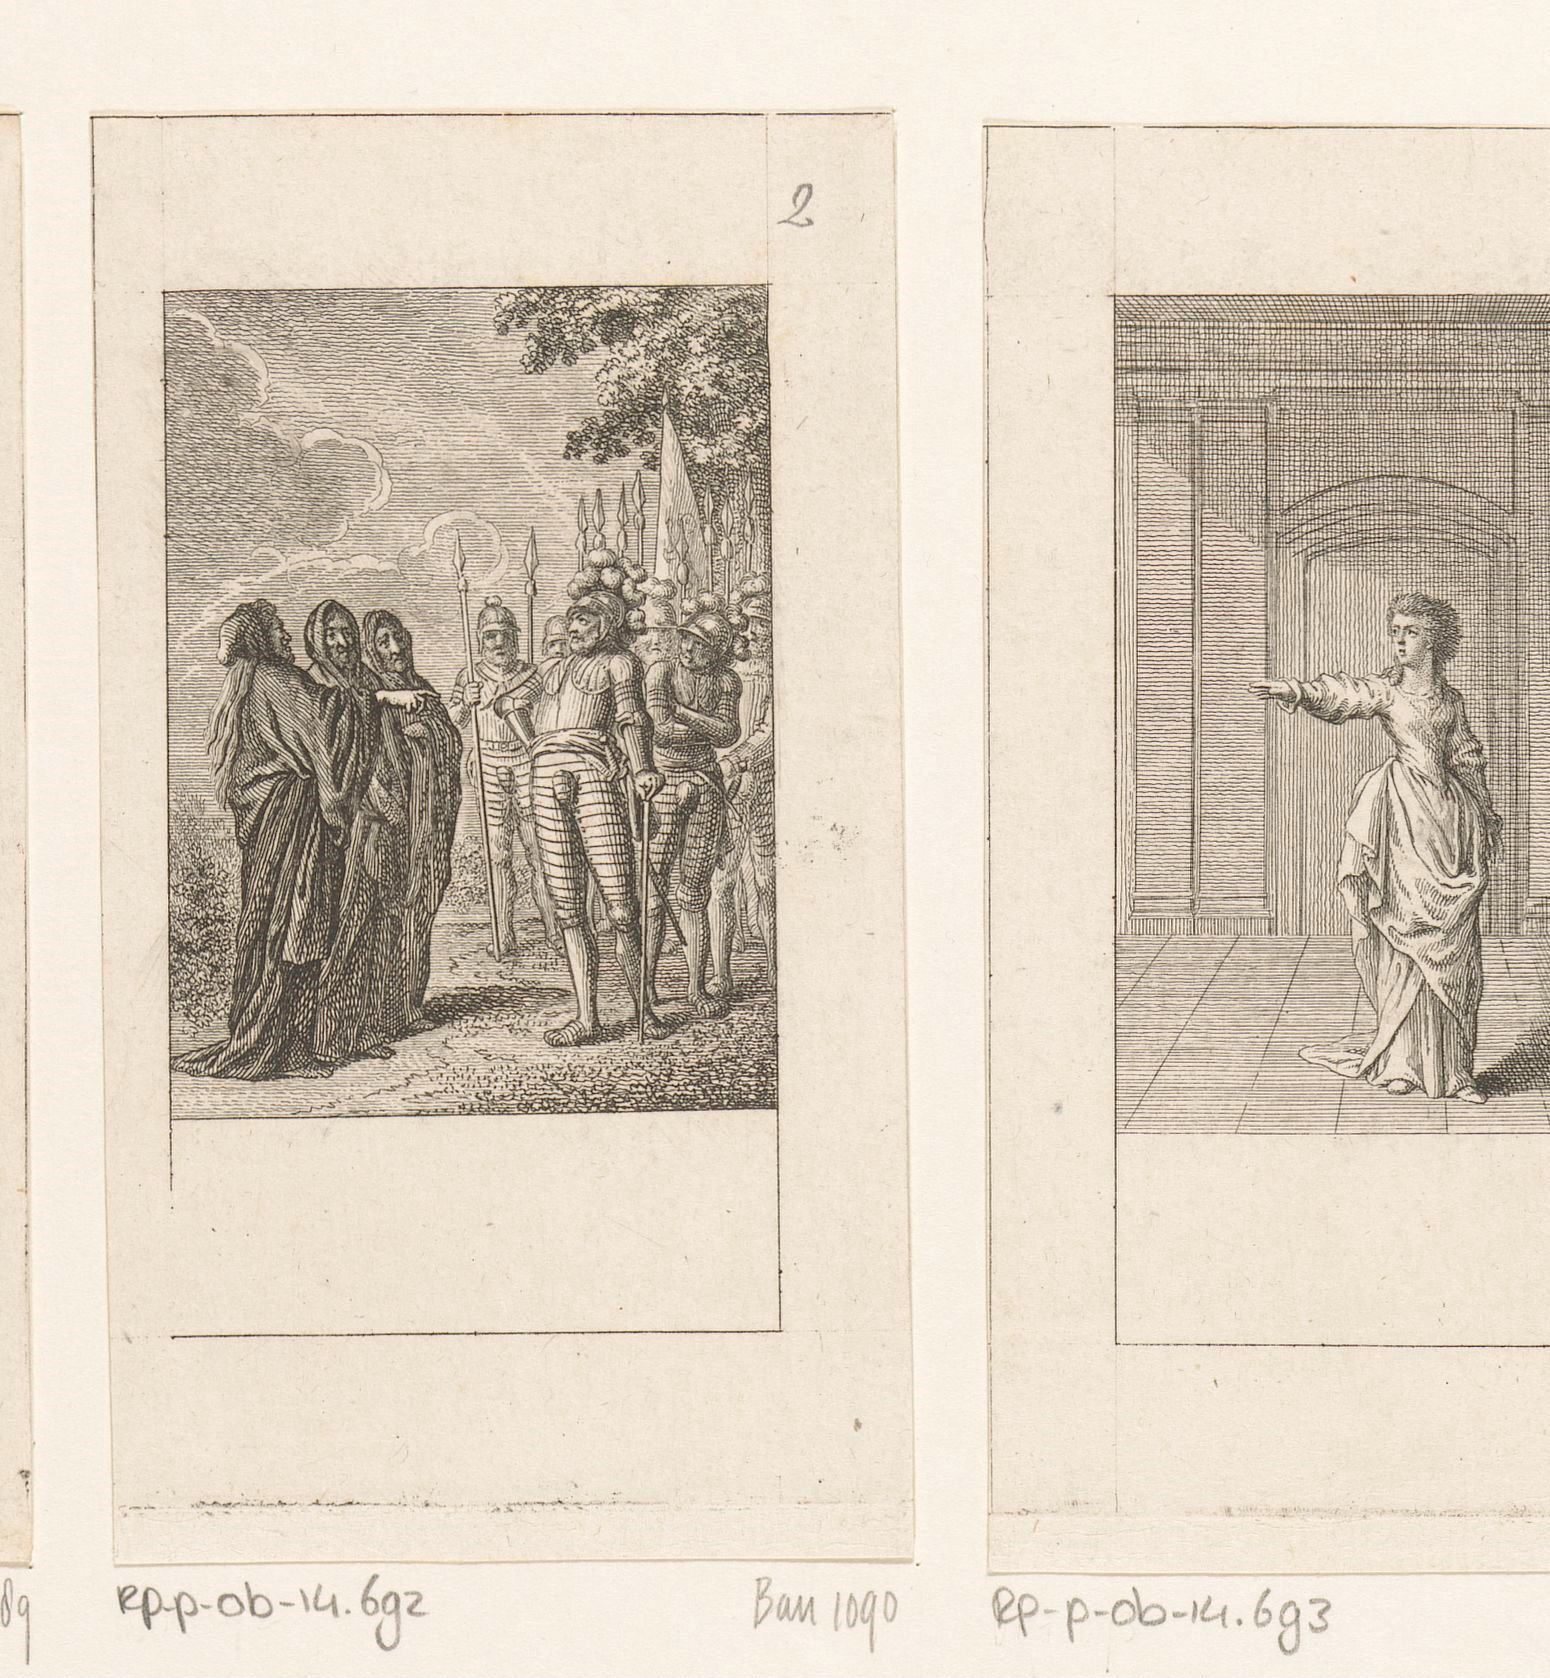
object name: print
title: Macbeth hoort de profetie van de heksen aan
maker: daniel nikolaus chodowiecki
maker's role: draughtsman, print maker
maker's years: 1726-1801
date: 1784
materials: paper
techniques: etching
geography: berlin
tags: william shakespeare, groups of witches, macbeth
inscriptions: collector's mark: Lugt 2228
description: Vervaardigd voor William Shakespeares 'Macbeth'. Latere staat gebruikt voor: Goettinger Taschen Calender vom Jahre 1785. Göttingen: Johann Christoph Dietrich, 1784.